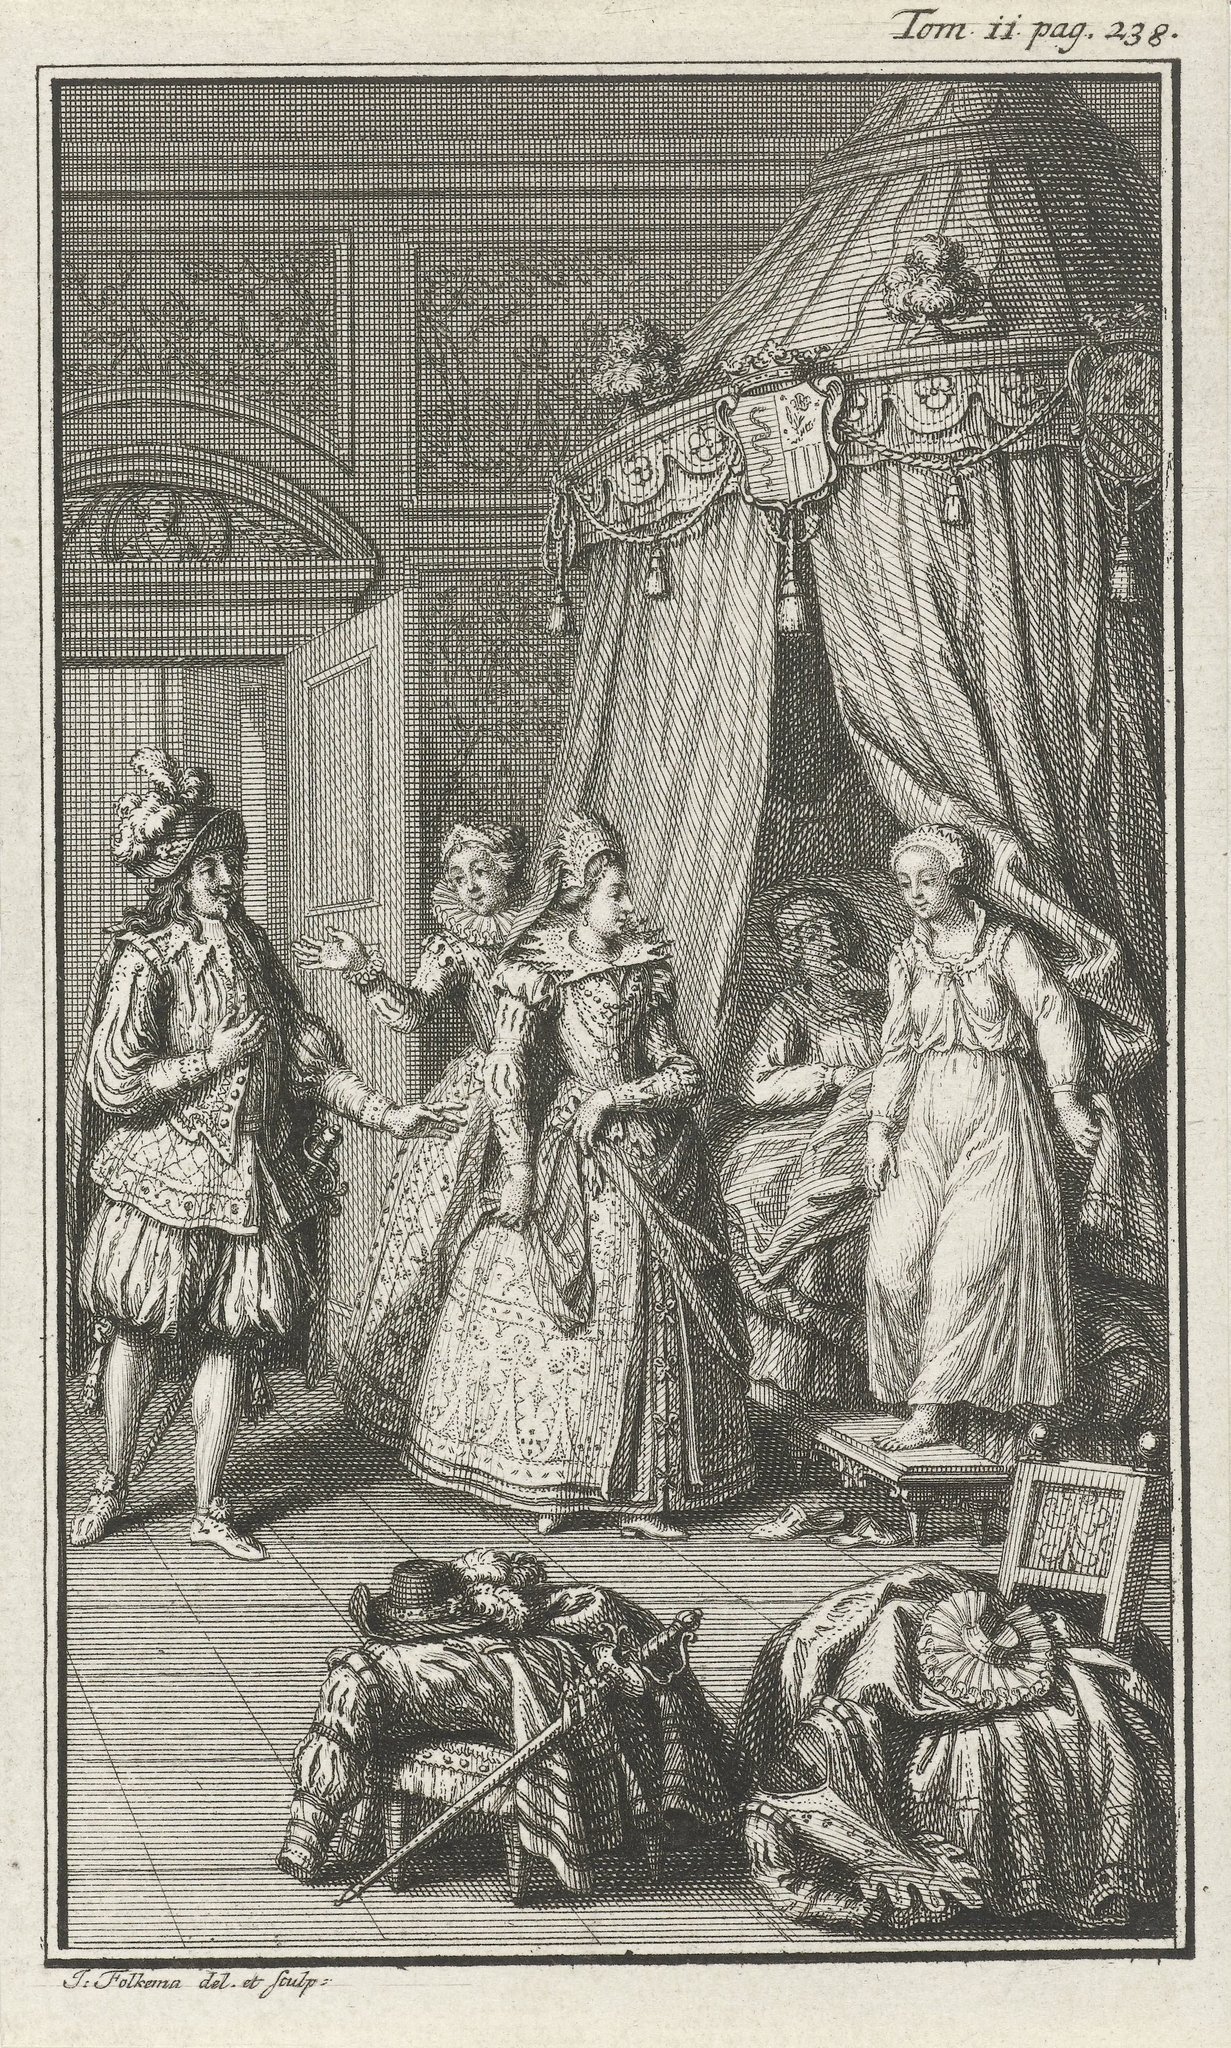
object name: print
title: Liefdespaar betrapt in een slaapvertrek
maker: jacob folkema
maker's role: draughtsman, print maker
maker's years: 1692-1767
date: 1702-1767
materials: paper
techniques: etching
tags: interrupted meeting, lovers caught by surprise, bedroom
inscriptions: collector's mark: Lugt 240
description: Drie rijk geklede figuren zijn een slaapvertrek binnengegaan en treffen daar in bed een man en vrouw. De man is in bed blijven liggen terwijl de vrouw in nachthemd uit bed is gestapt. Op de voorgrond ligt uitgetrokken kleding over een stoel en een krukje. Prent rechtsboven gemerkt: Tom. ii. pag. 238.